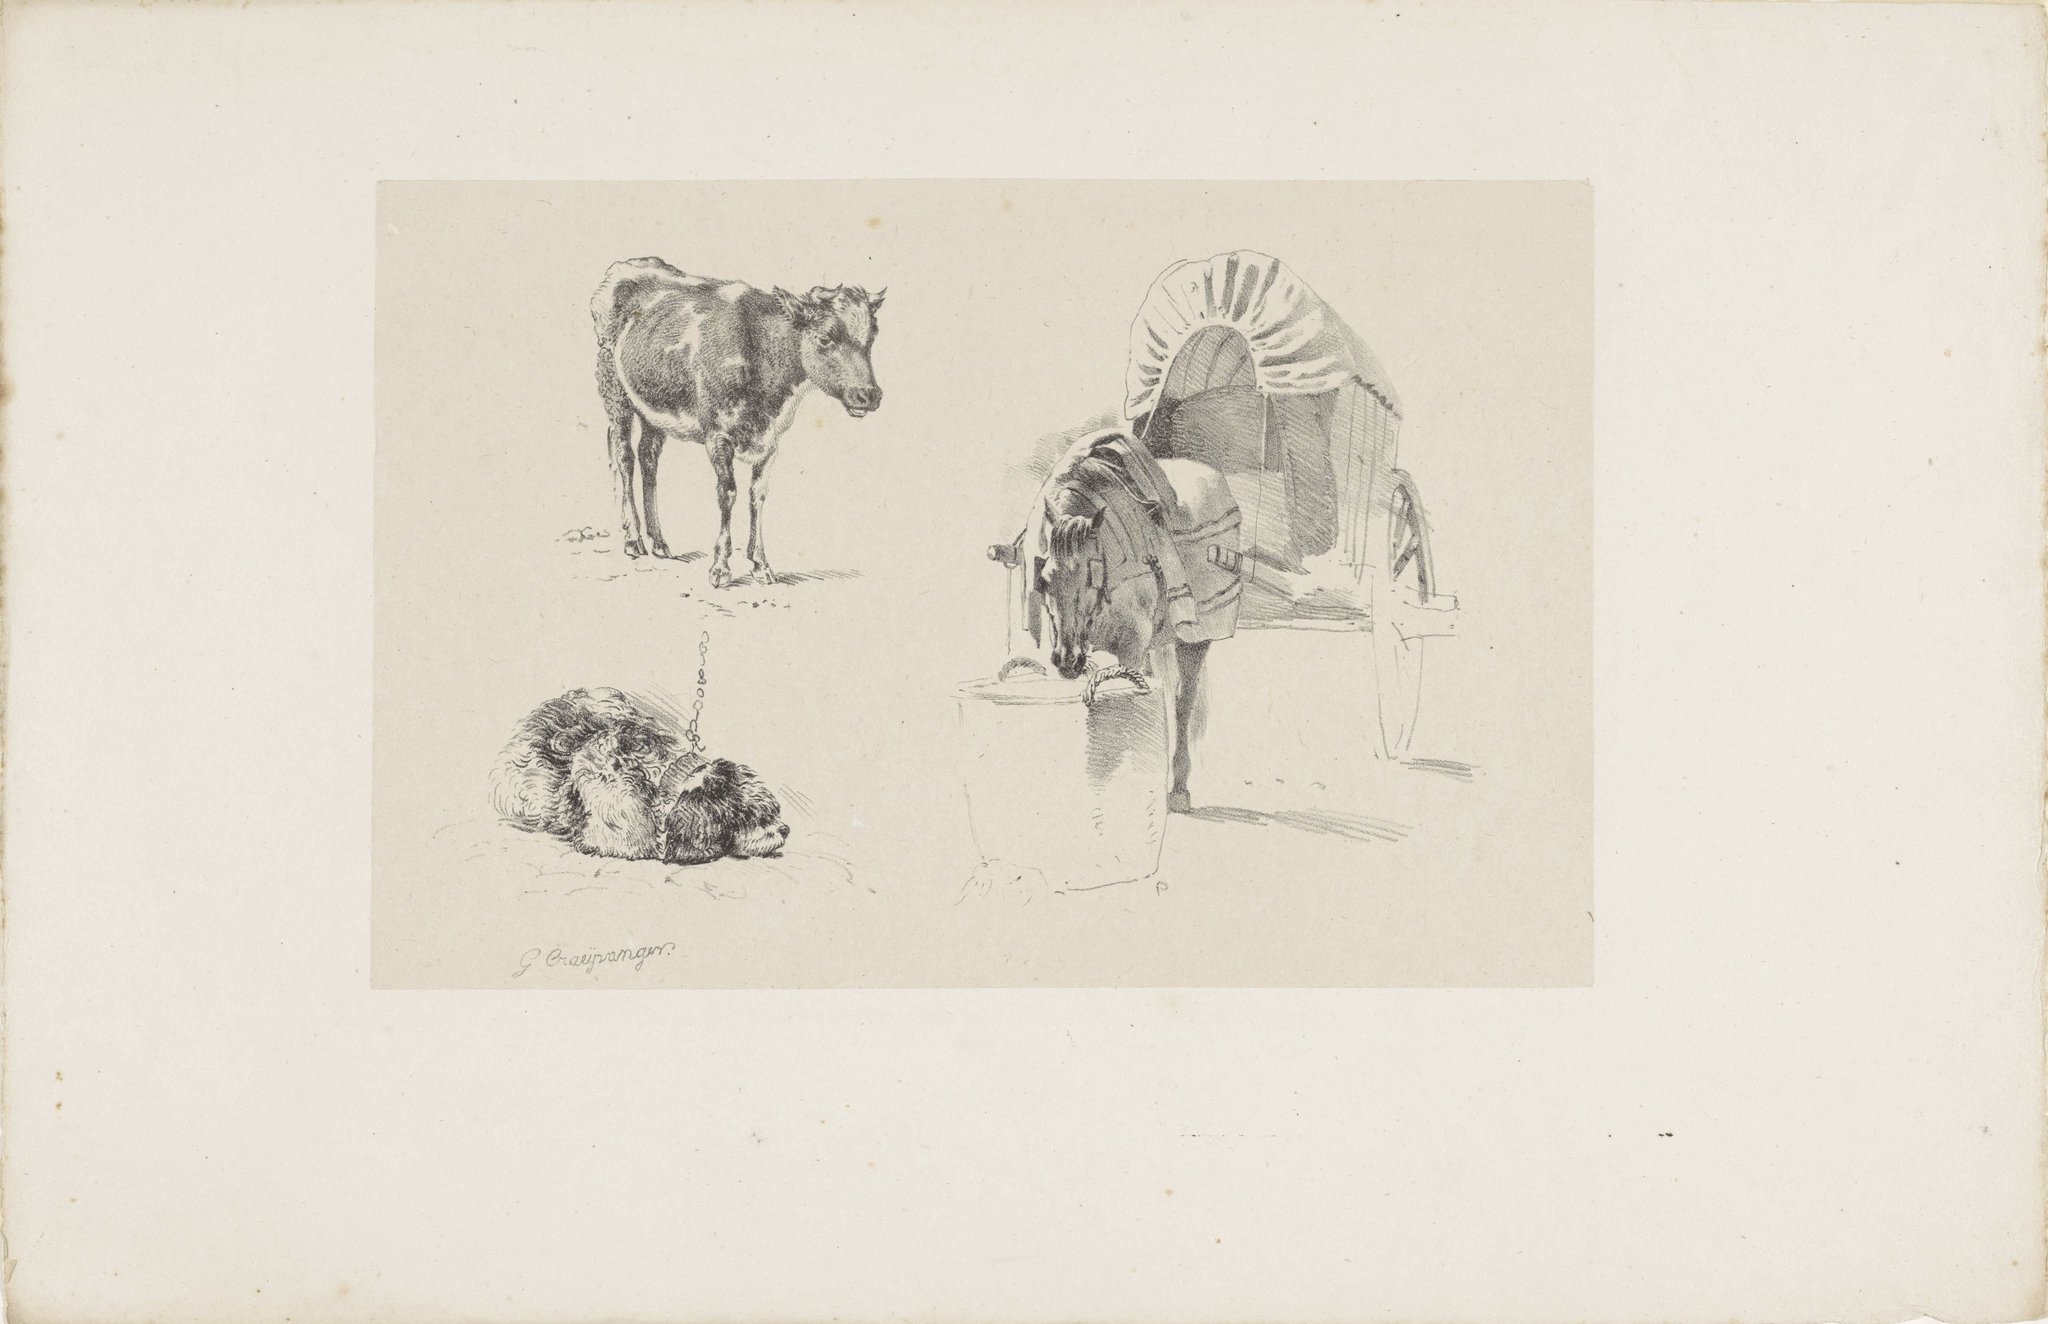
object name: print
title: Beesten Studien naar het Leven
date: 1827-1828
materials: paper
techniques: lithograph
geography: amsterdam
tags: calf, horse (+ conveyance for transport of loads and cargoes), dog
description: Waarschijnlijk is dit een prent voor: 'Beesten Studien naar het Leven op steen gebragt door G. Craeyvanger'. Amsterdam: Francois Buffa & Zoonen, 1828. Zie Swillens in Jaarboek Oud Utrecht. Volgens Swillens gedrukt door Ambroise Jobard. In Lijst van kunstwerken door beoefenaars en verzamelaars bijeengebragt, om verloot te worden ten behoeve van het vaderland; tentoongesteld te Amsterdam, in het nationale geregtshof, Amsterdam (C.A. Spin) 1831, p. 31, nr. 700 vermeld als uitgave van Daiwaille en Veldhuijzen. Daiwaille had eerder samengewerkt met Ambroise Jobard.